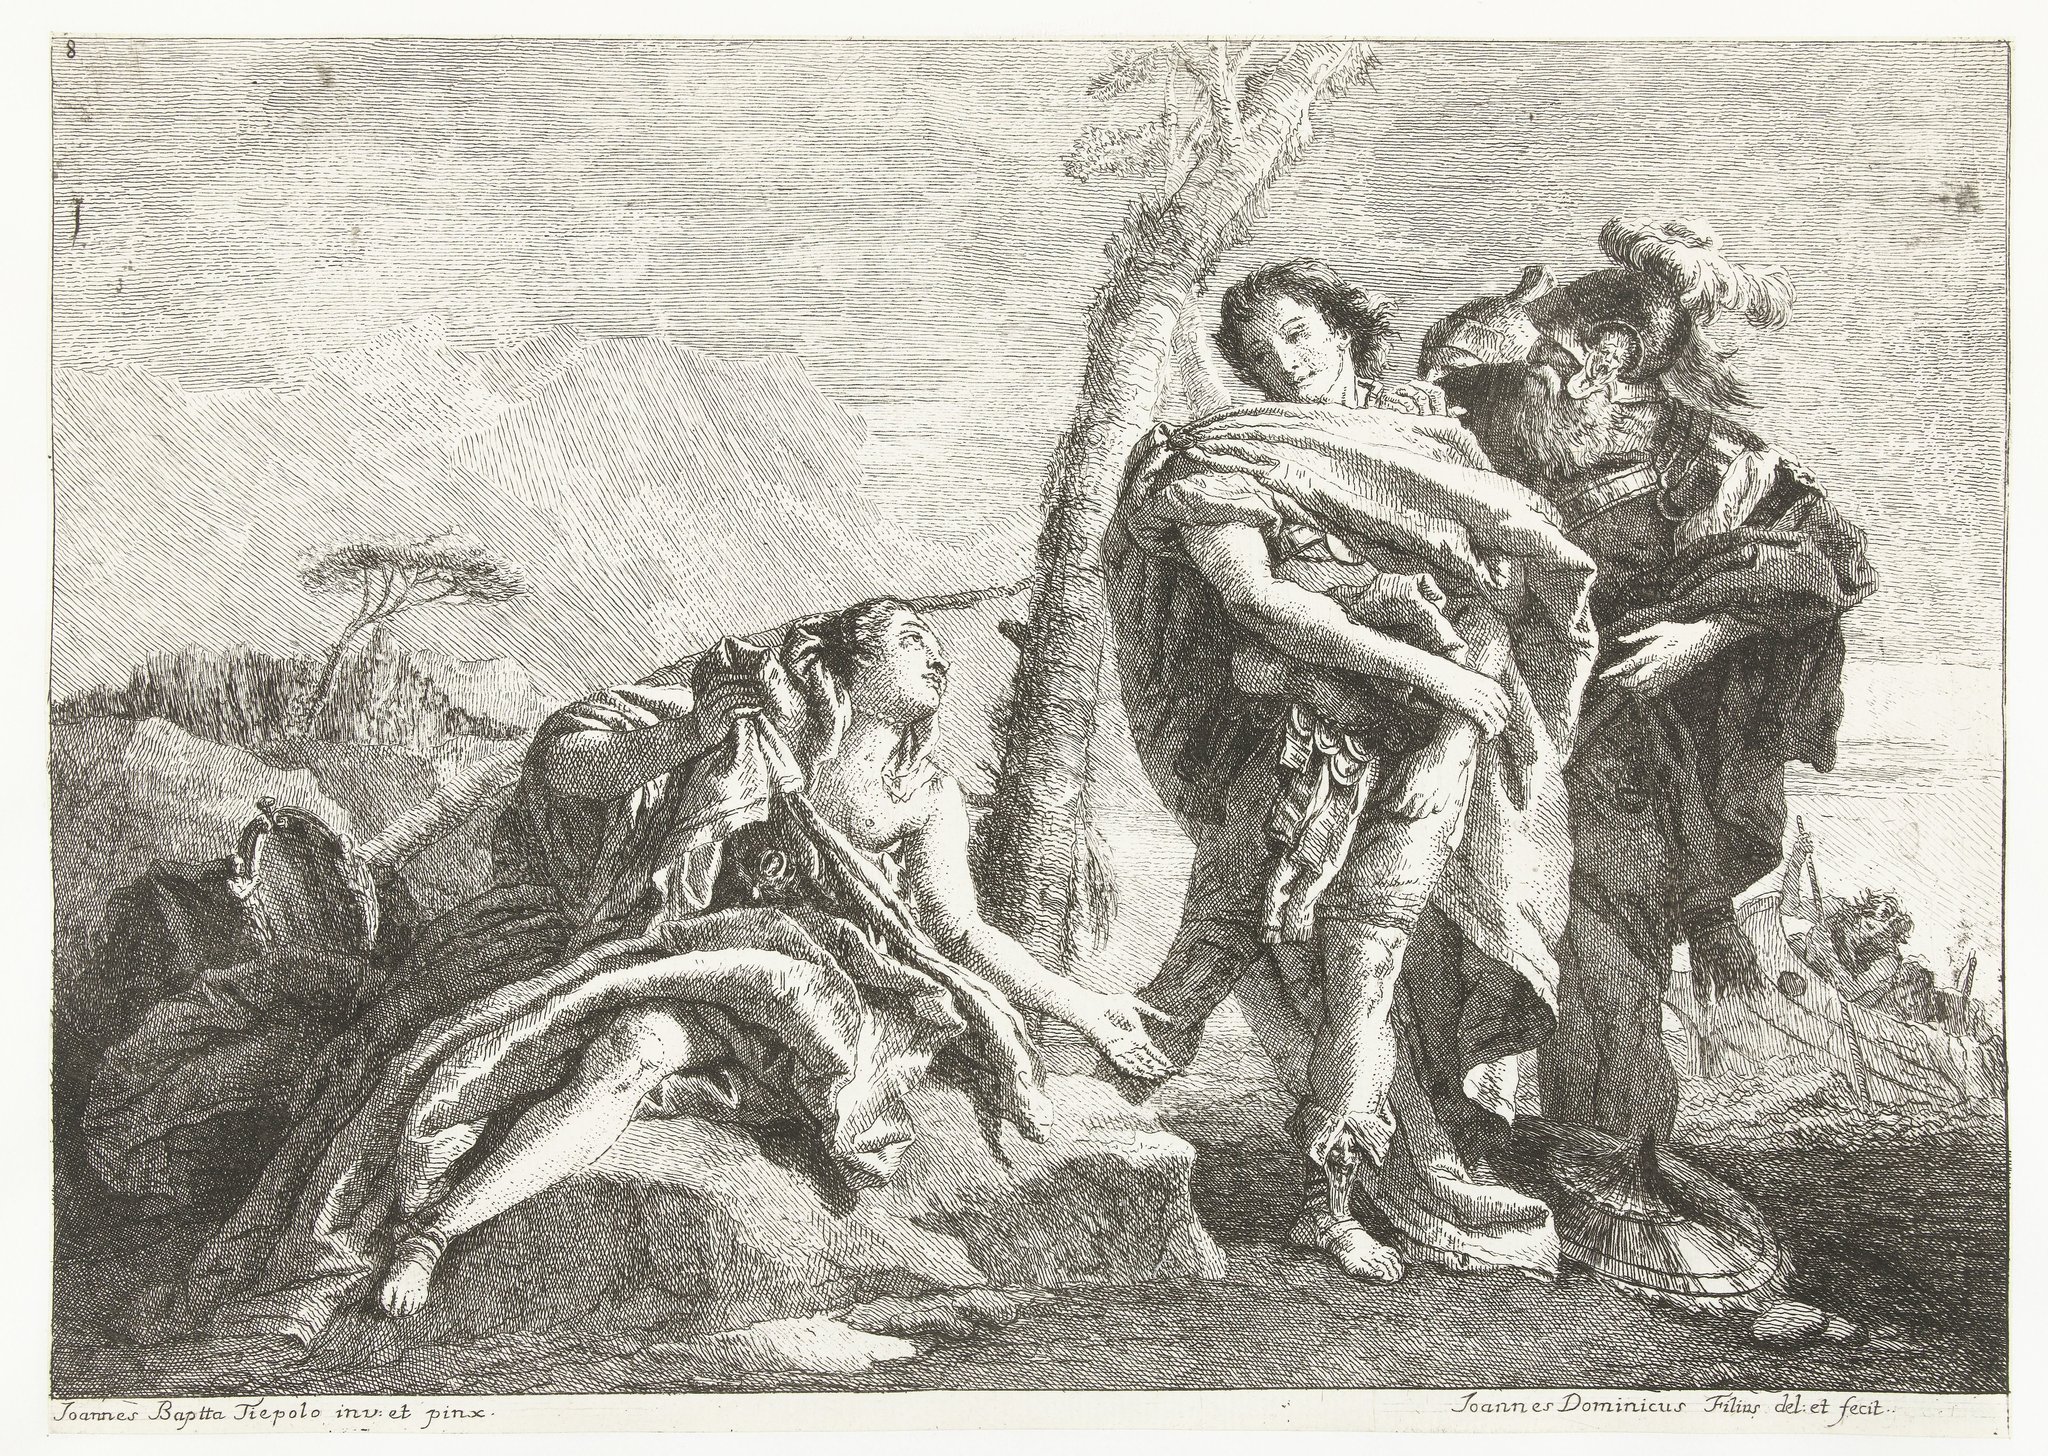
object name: print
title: Rinaldo Abandons Armida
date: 1757-1760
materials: paper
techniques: etching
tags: rinaldo, armida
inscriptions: collector's mark: Lugt 2228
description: This is a scene from the epic poem Gerusalemme Liberata (Jerusalem liberated) by Torquato Tasso. A story in this 16th-century epos about the First Crusade tells of the sorceress Armida who falls in love with the valiant crusader Rinaldo. She enchants him, and he falls under her spell. When the charm is ultimately broken, Rinaldo, filled with revulsion, turns away from Armida – the moment depicted here.